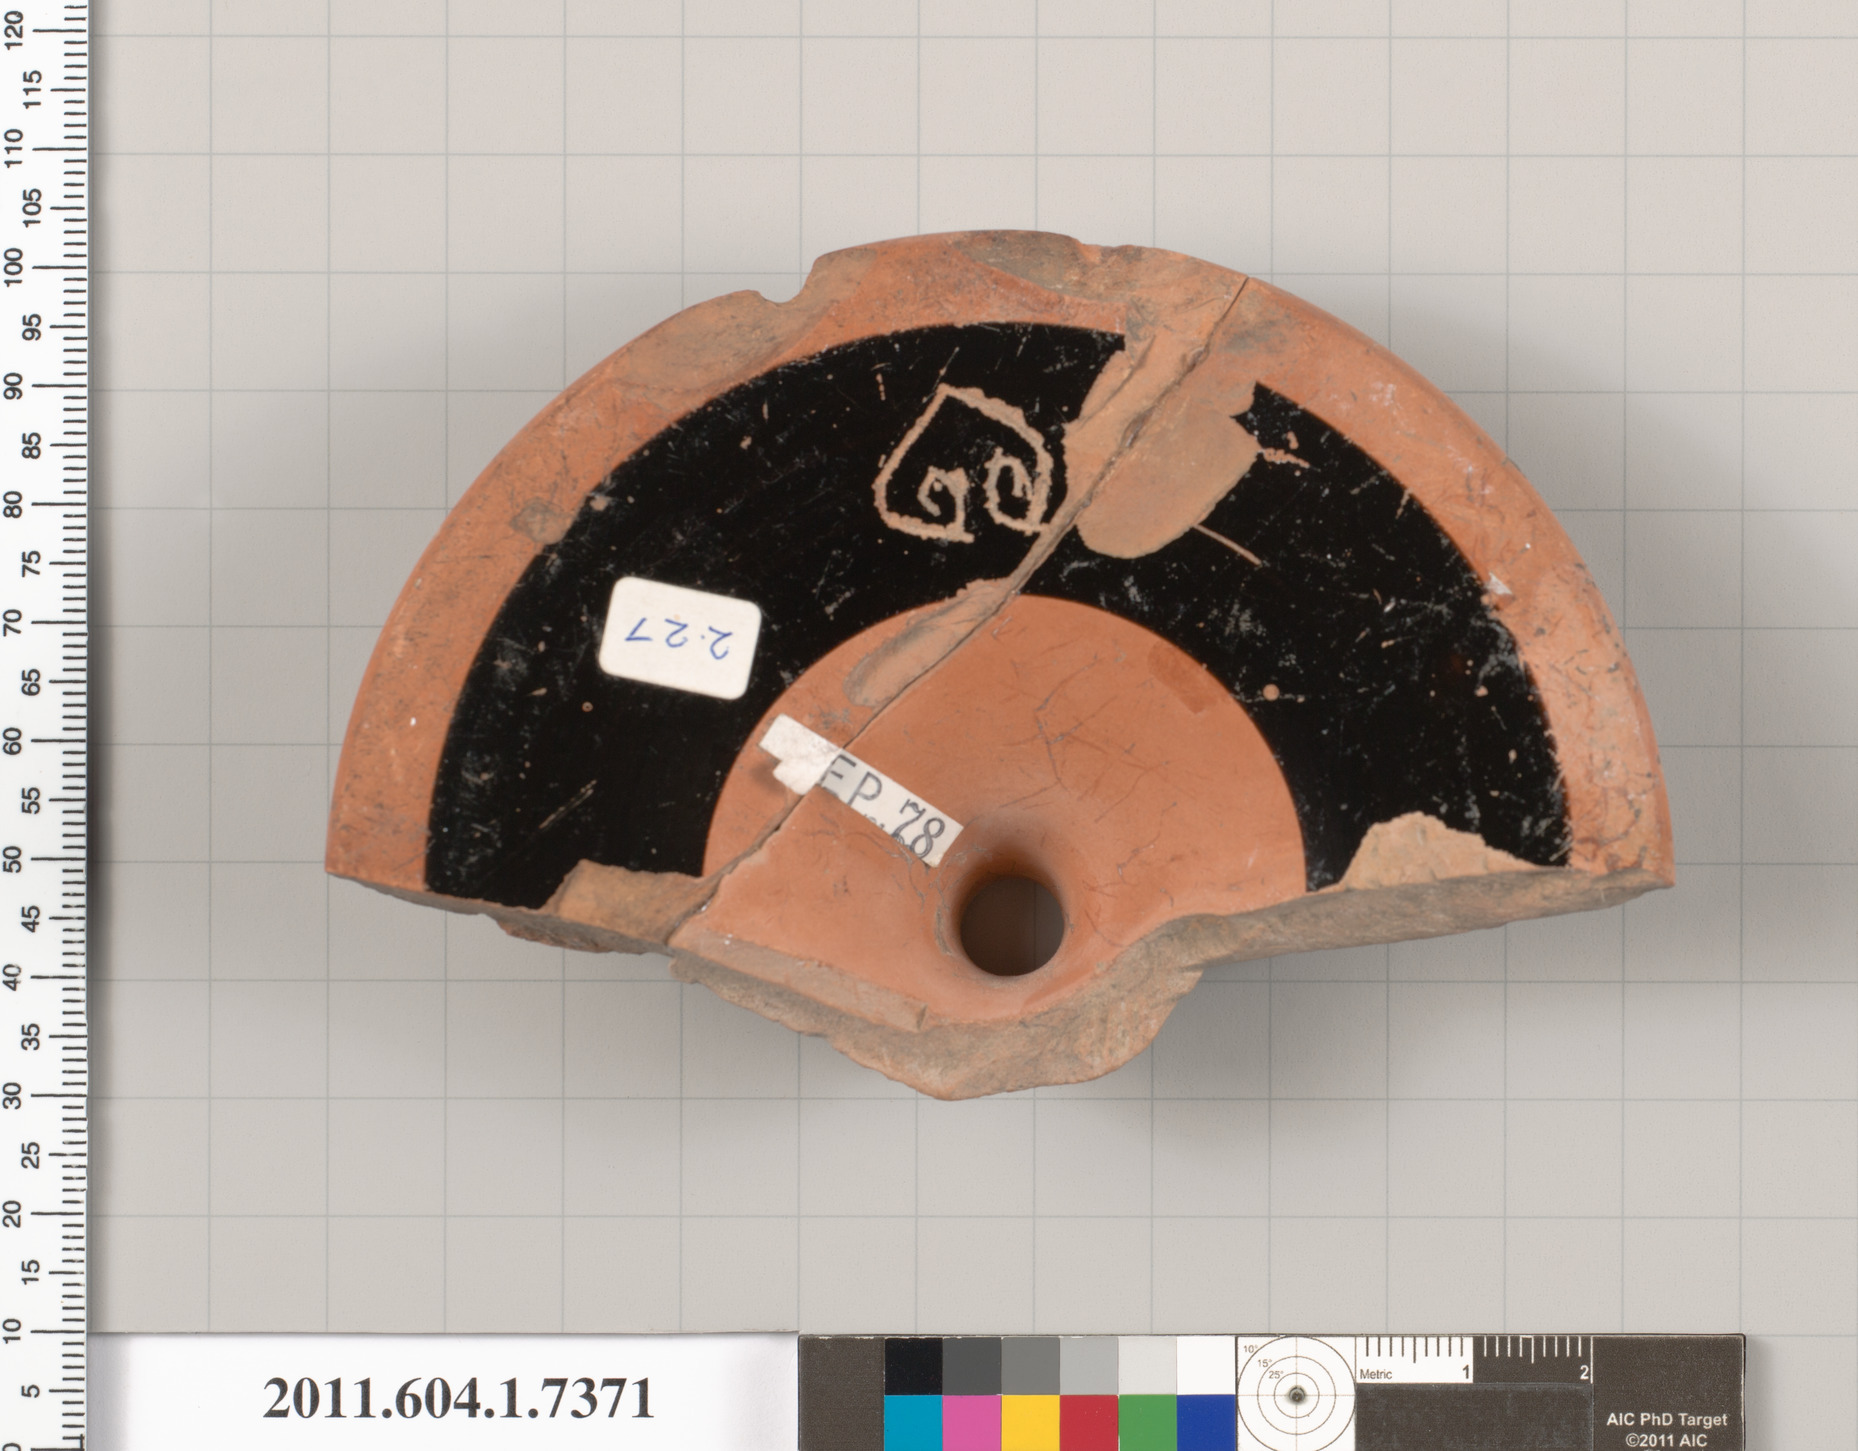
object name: kylix fragment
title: Terracotta fragment of a kylix (drinking cup)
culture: greek, attic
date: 500-480 BCE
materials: terracotta